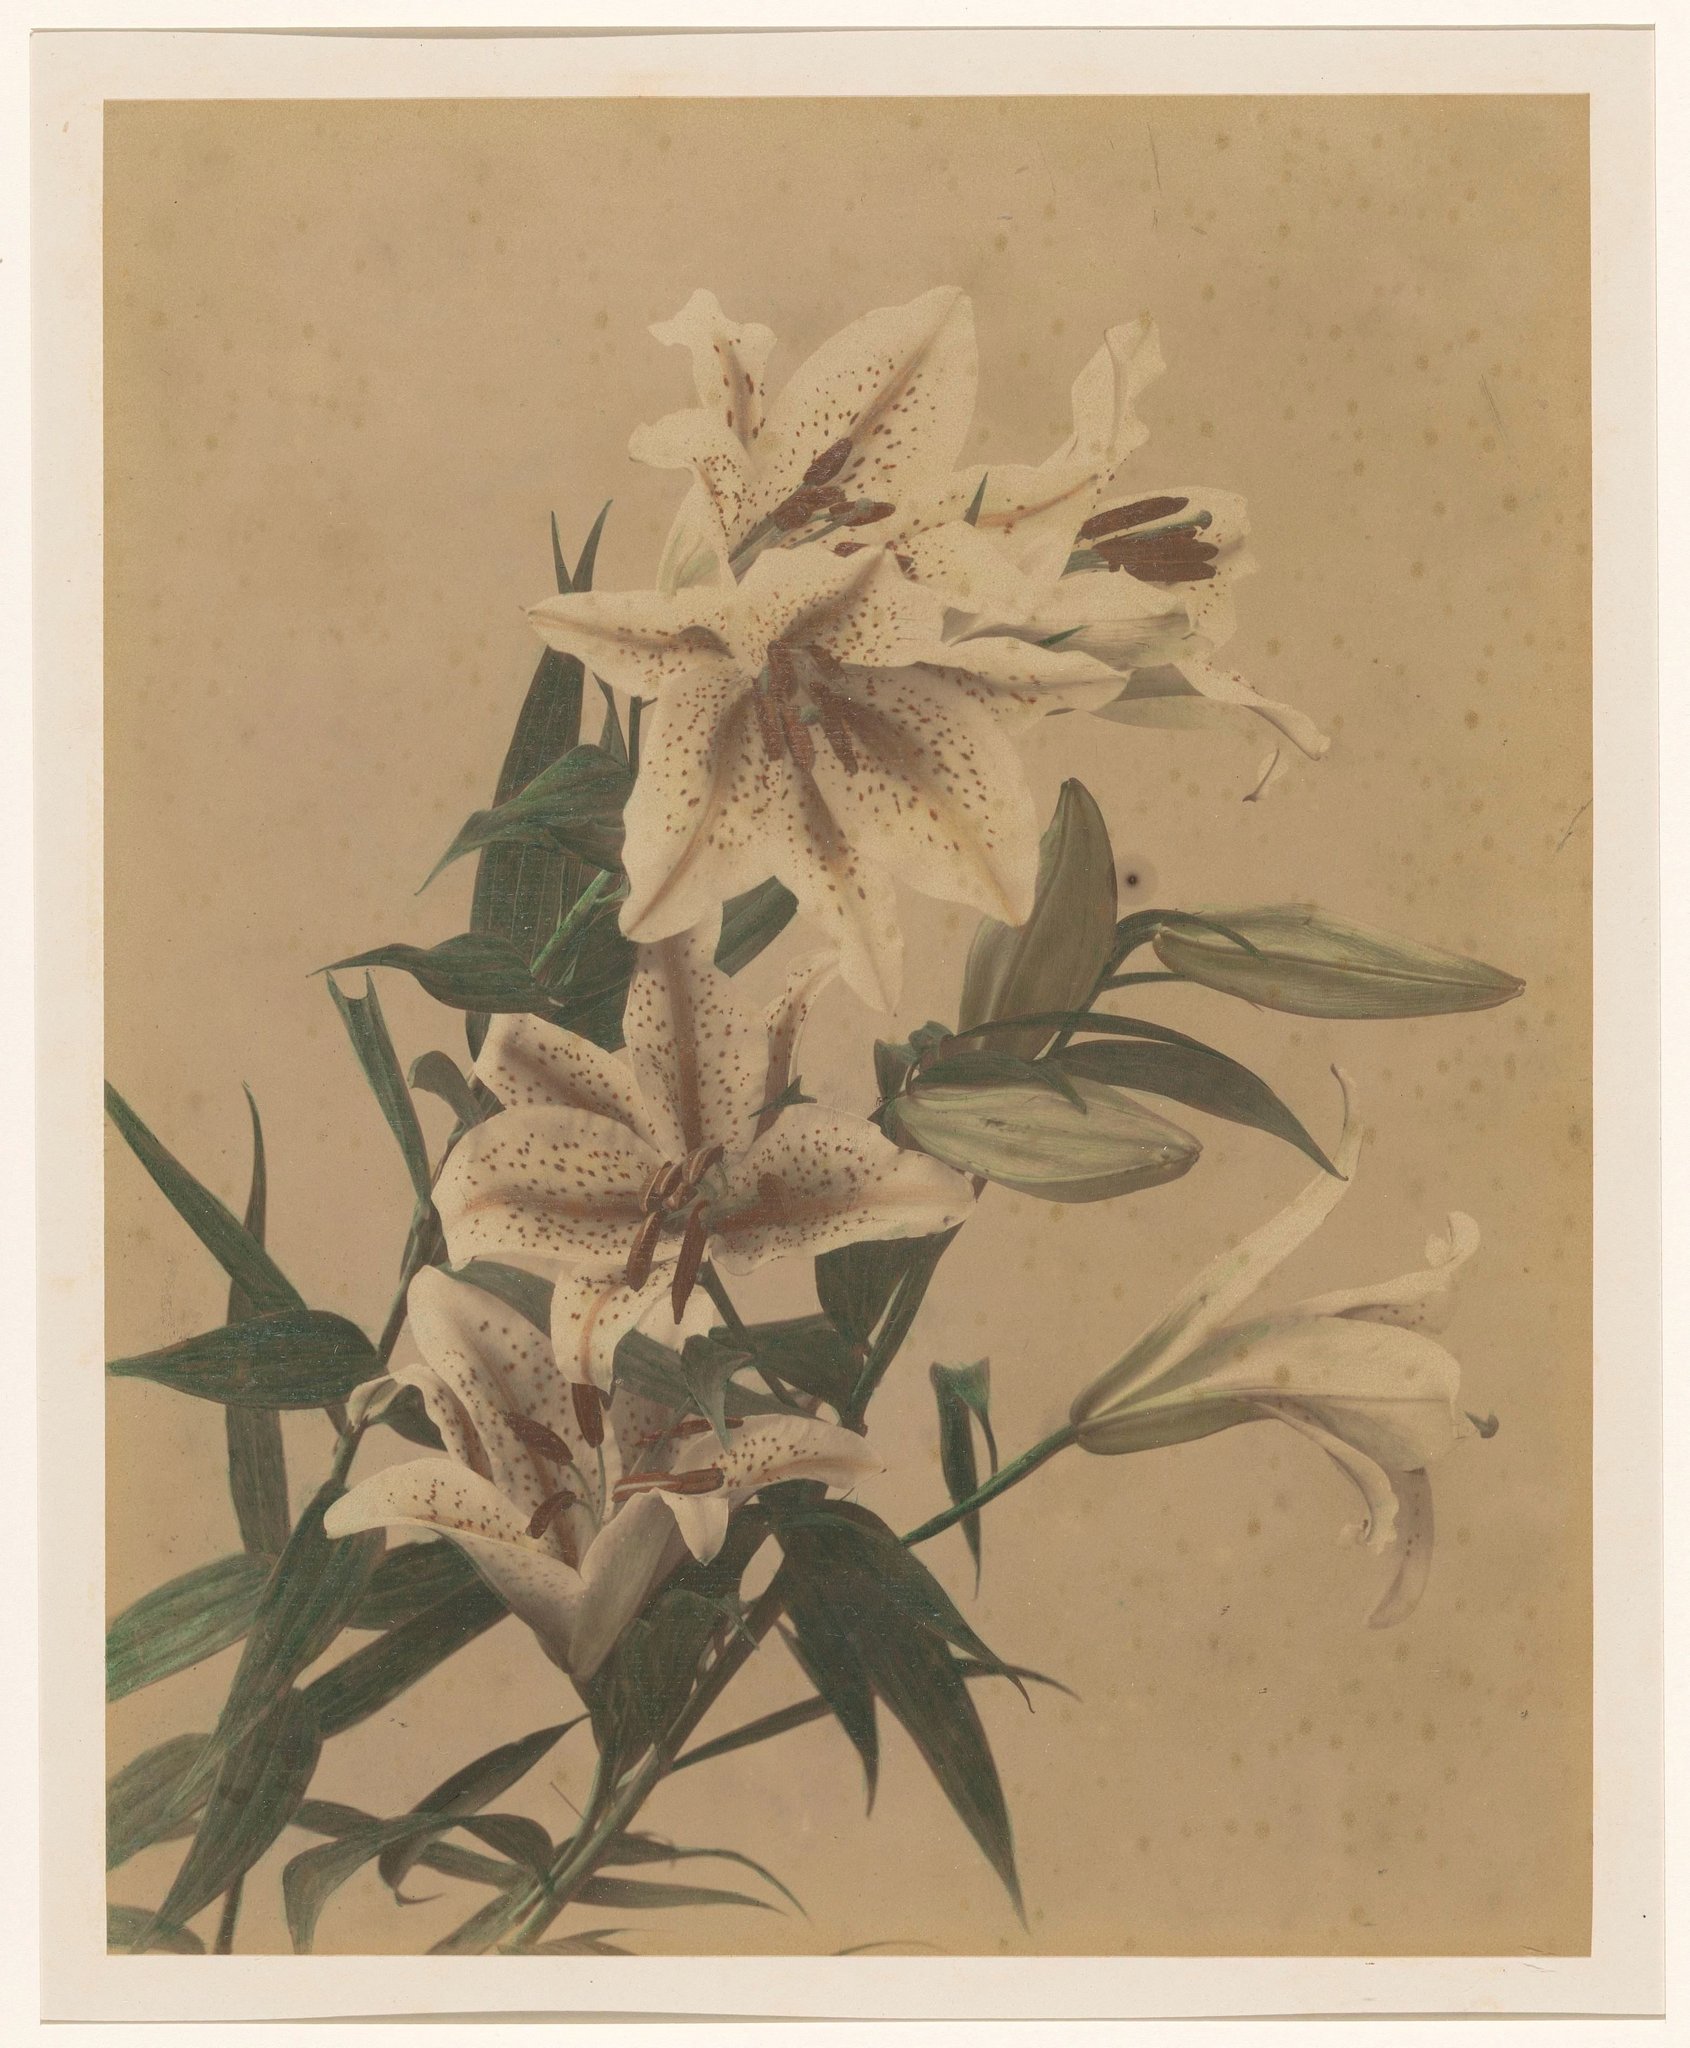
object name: photograph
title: Tijgerlelies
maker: Anonymous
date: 1855-1890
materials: cardboard, paper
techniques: albumen print, hand coloring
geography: japan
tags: flowers: lily, japan